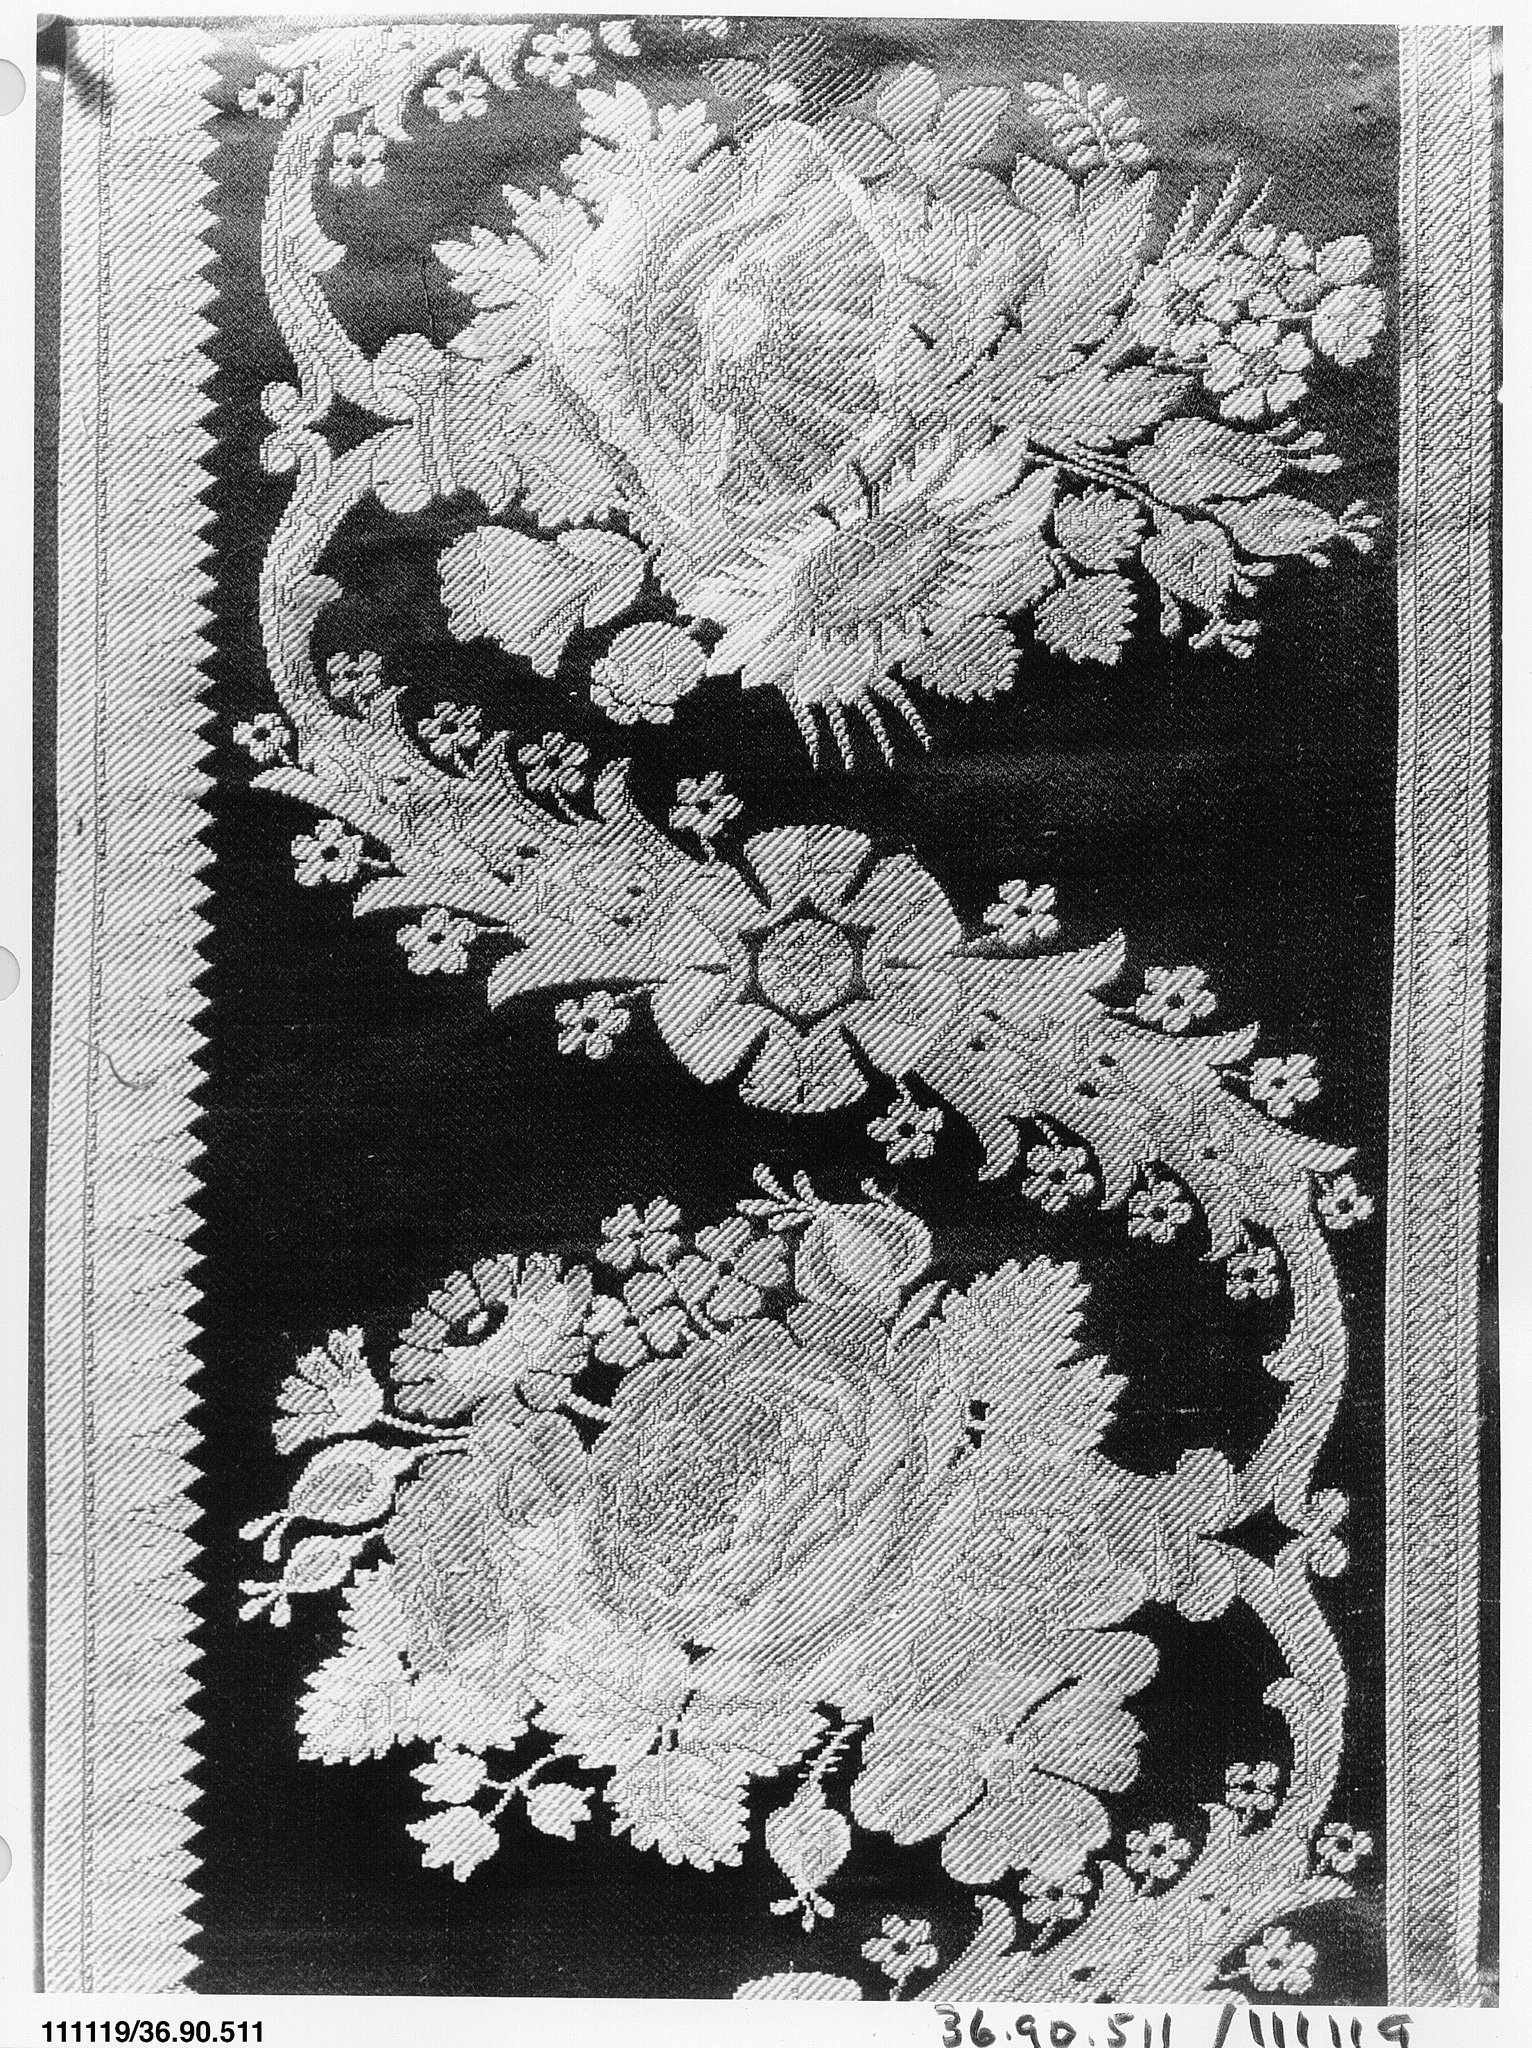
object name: piece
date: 1801-1833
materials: silk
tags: flowers